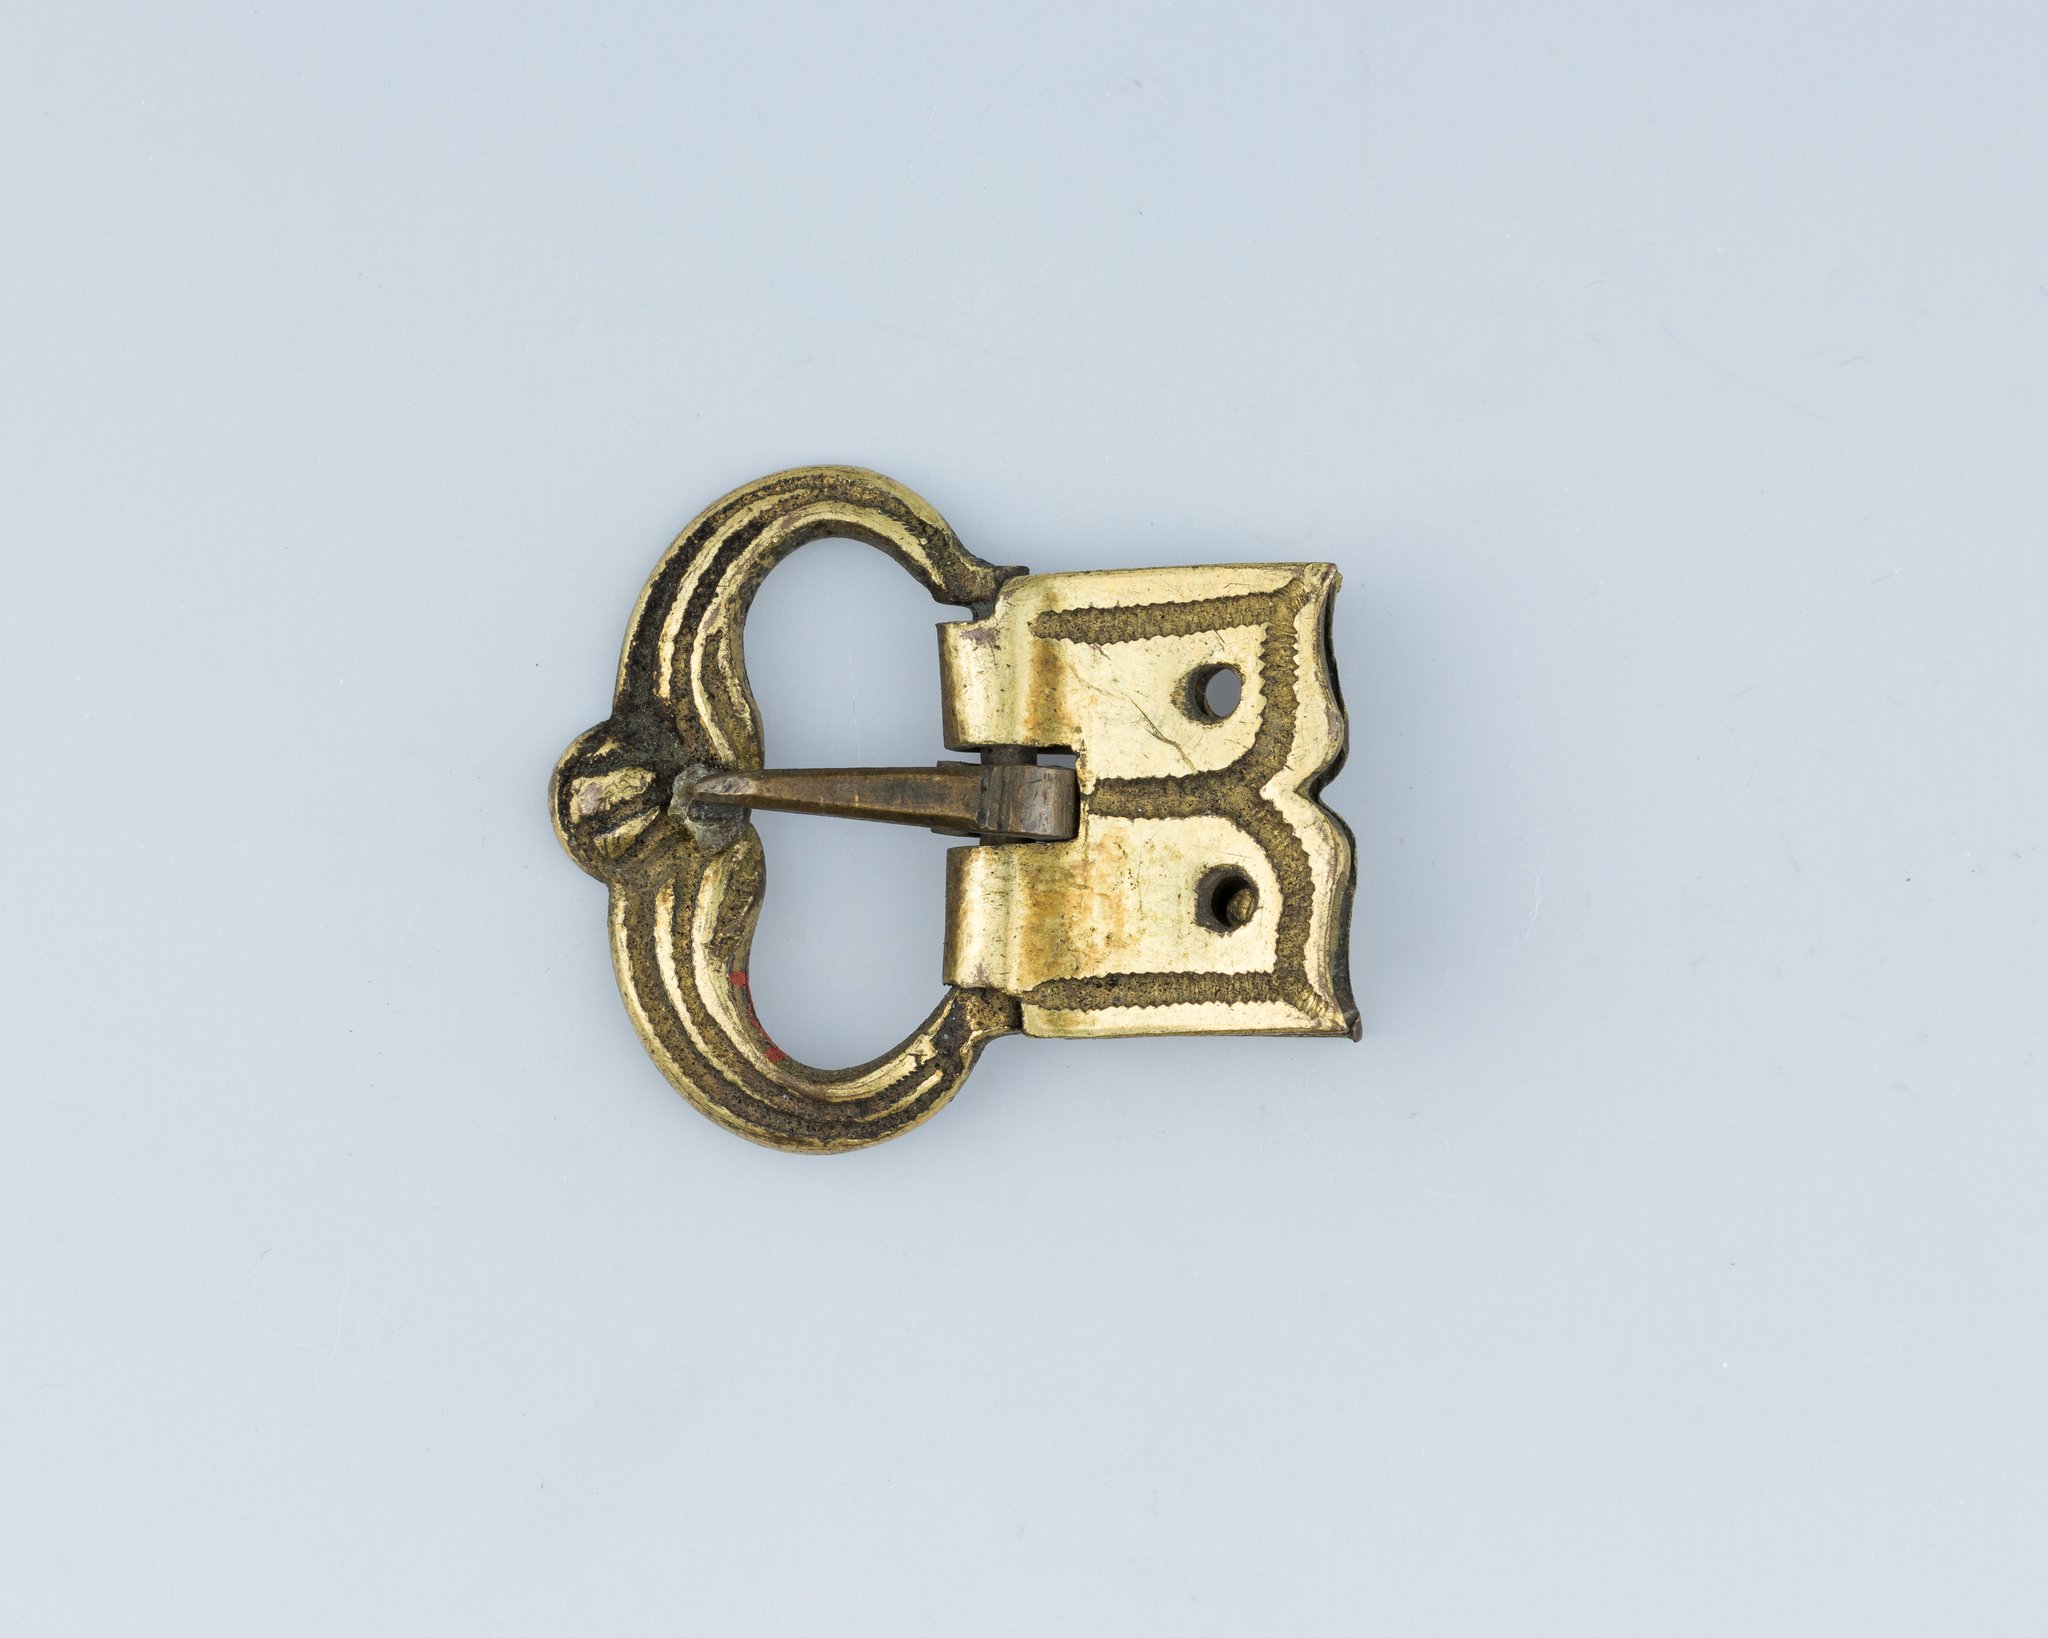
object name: buckle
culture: spanish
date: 1301-1500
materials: brass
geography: spain